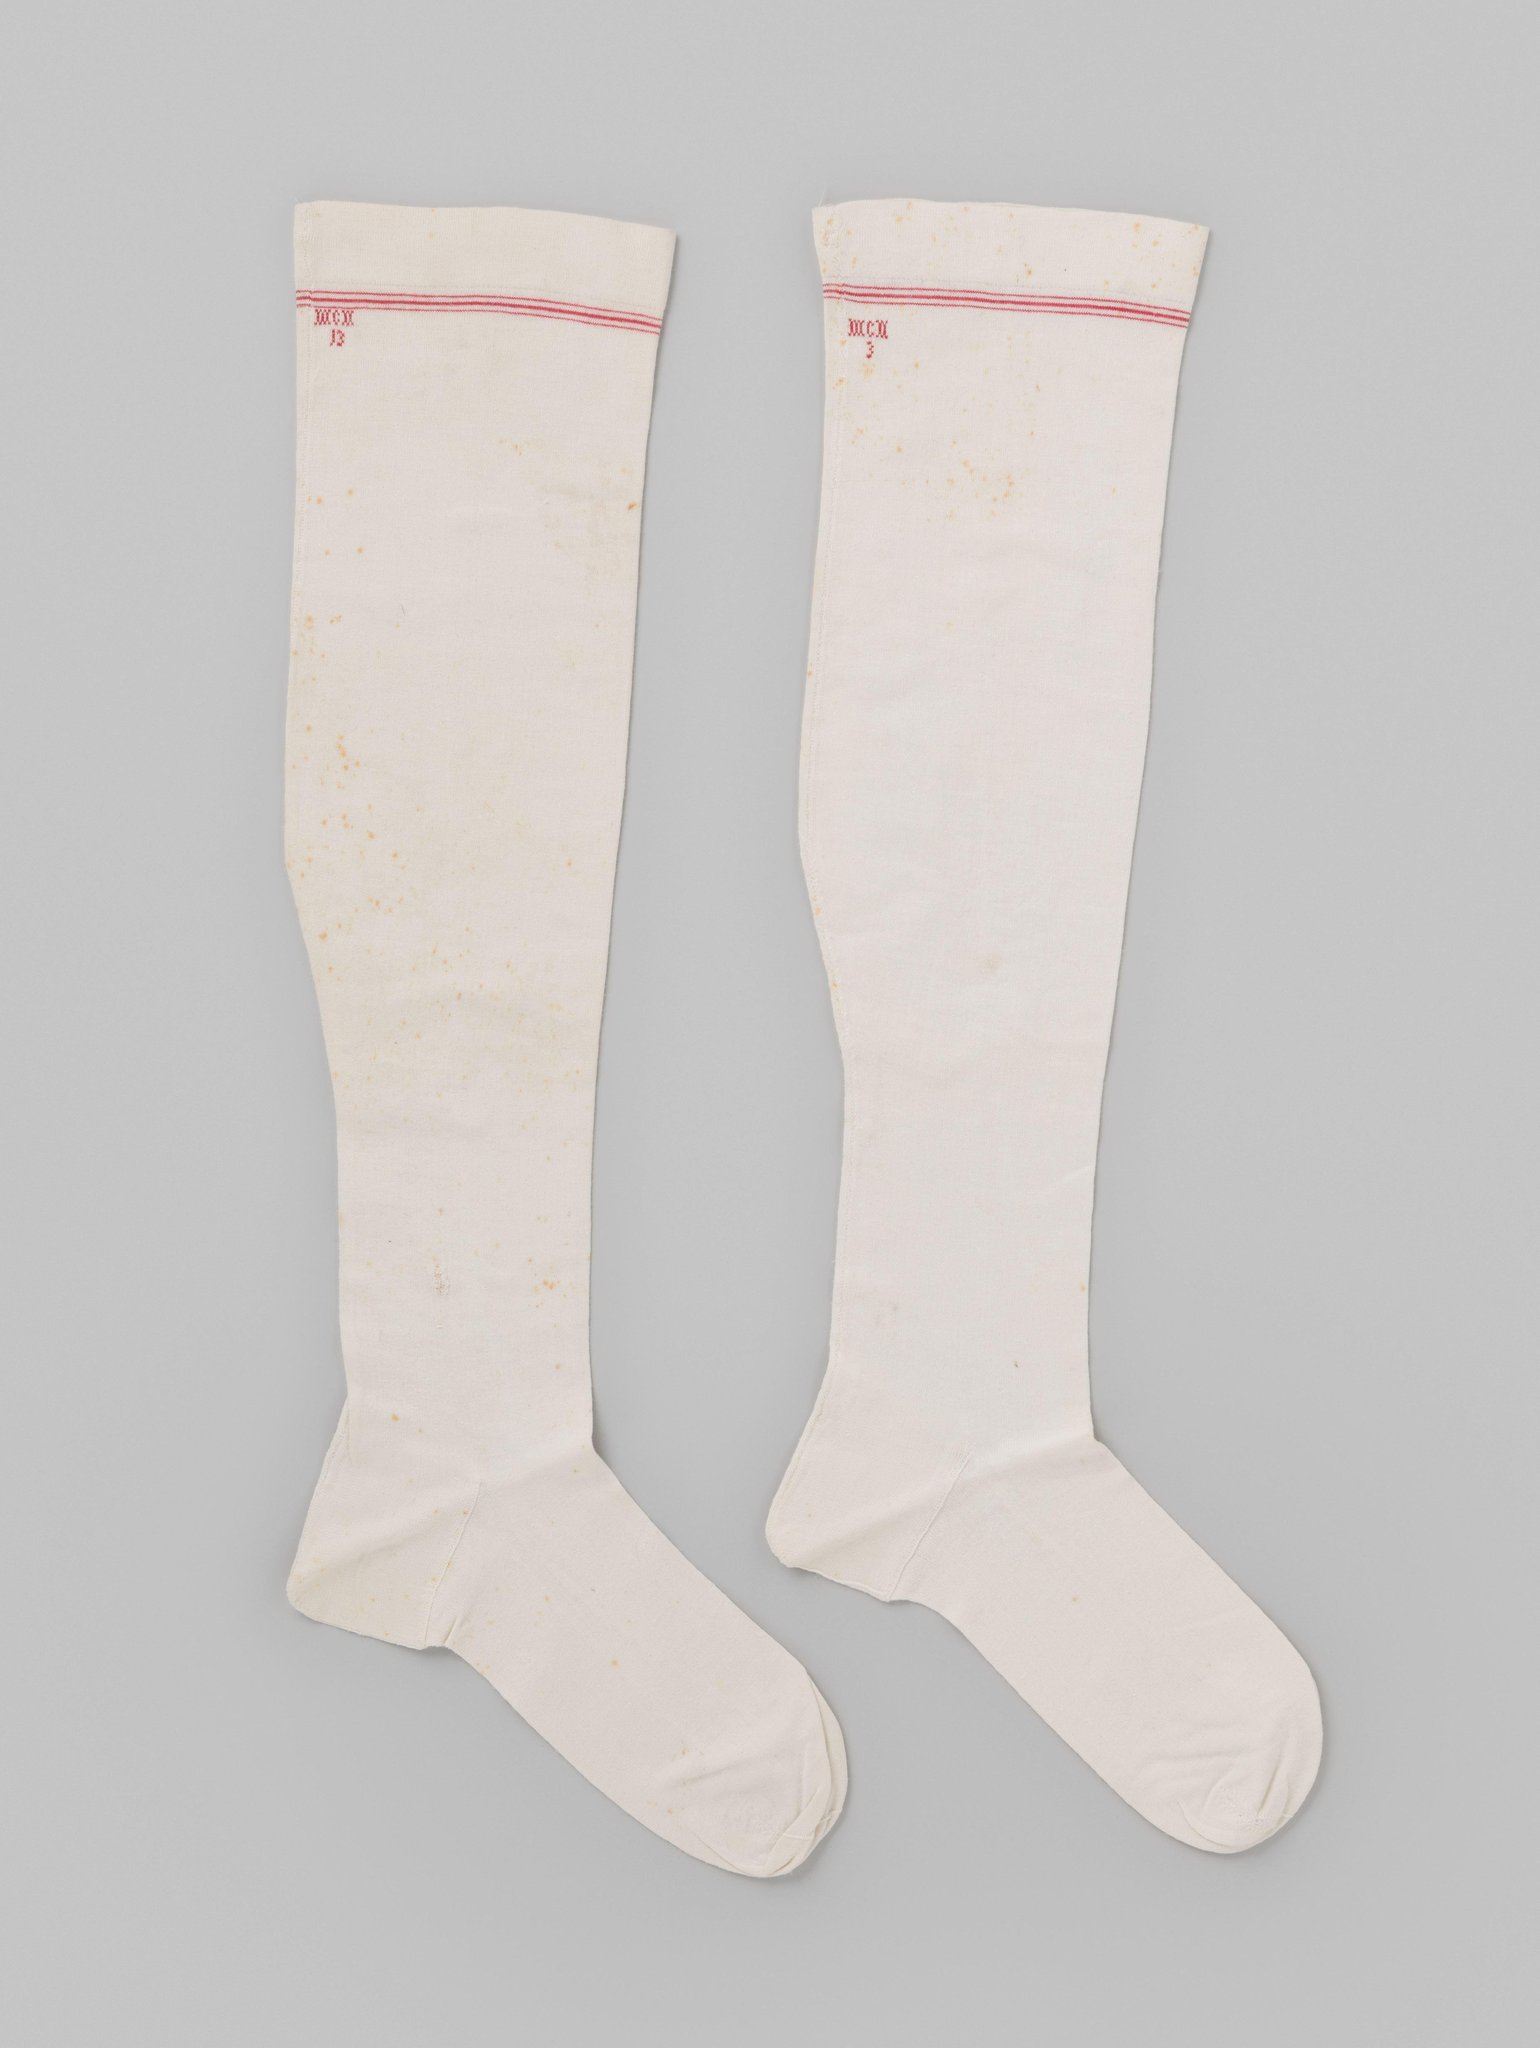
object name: clothing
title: Kous van fijne effen witte katoenen tricot met drie smalle streepjes onder de boord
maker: Anonymous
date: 1835-1865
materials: cotton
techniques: cross stitching, embroidered, knitting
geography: netherlands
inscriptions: inscription: ‘'MCN 13'’, initials: ‘'G'’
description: Kous van fijne effen witte katoenen tricot met drie smalle rode streepjes onder de boord. Naad middenachter. In rood onder de boord in kruissteek: 'MCN 13' en in de boord meegebreid de letter 'G'.